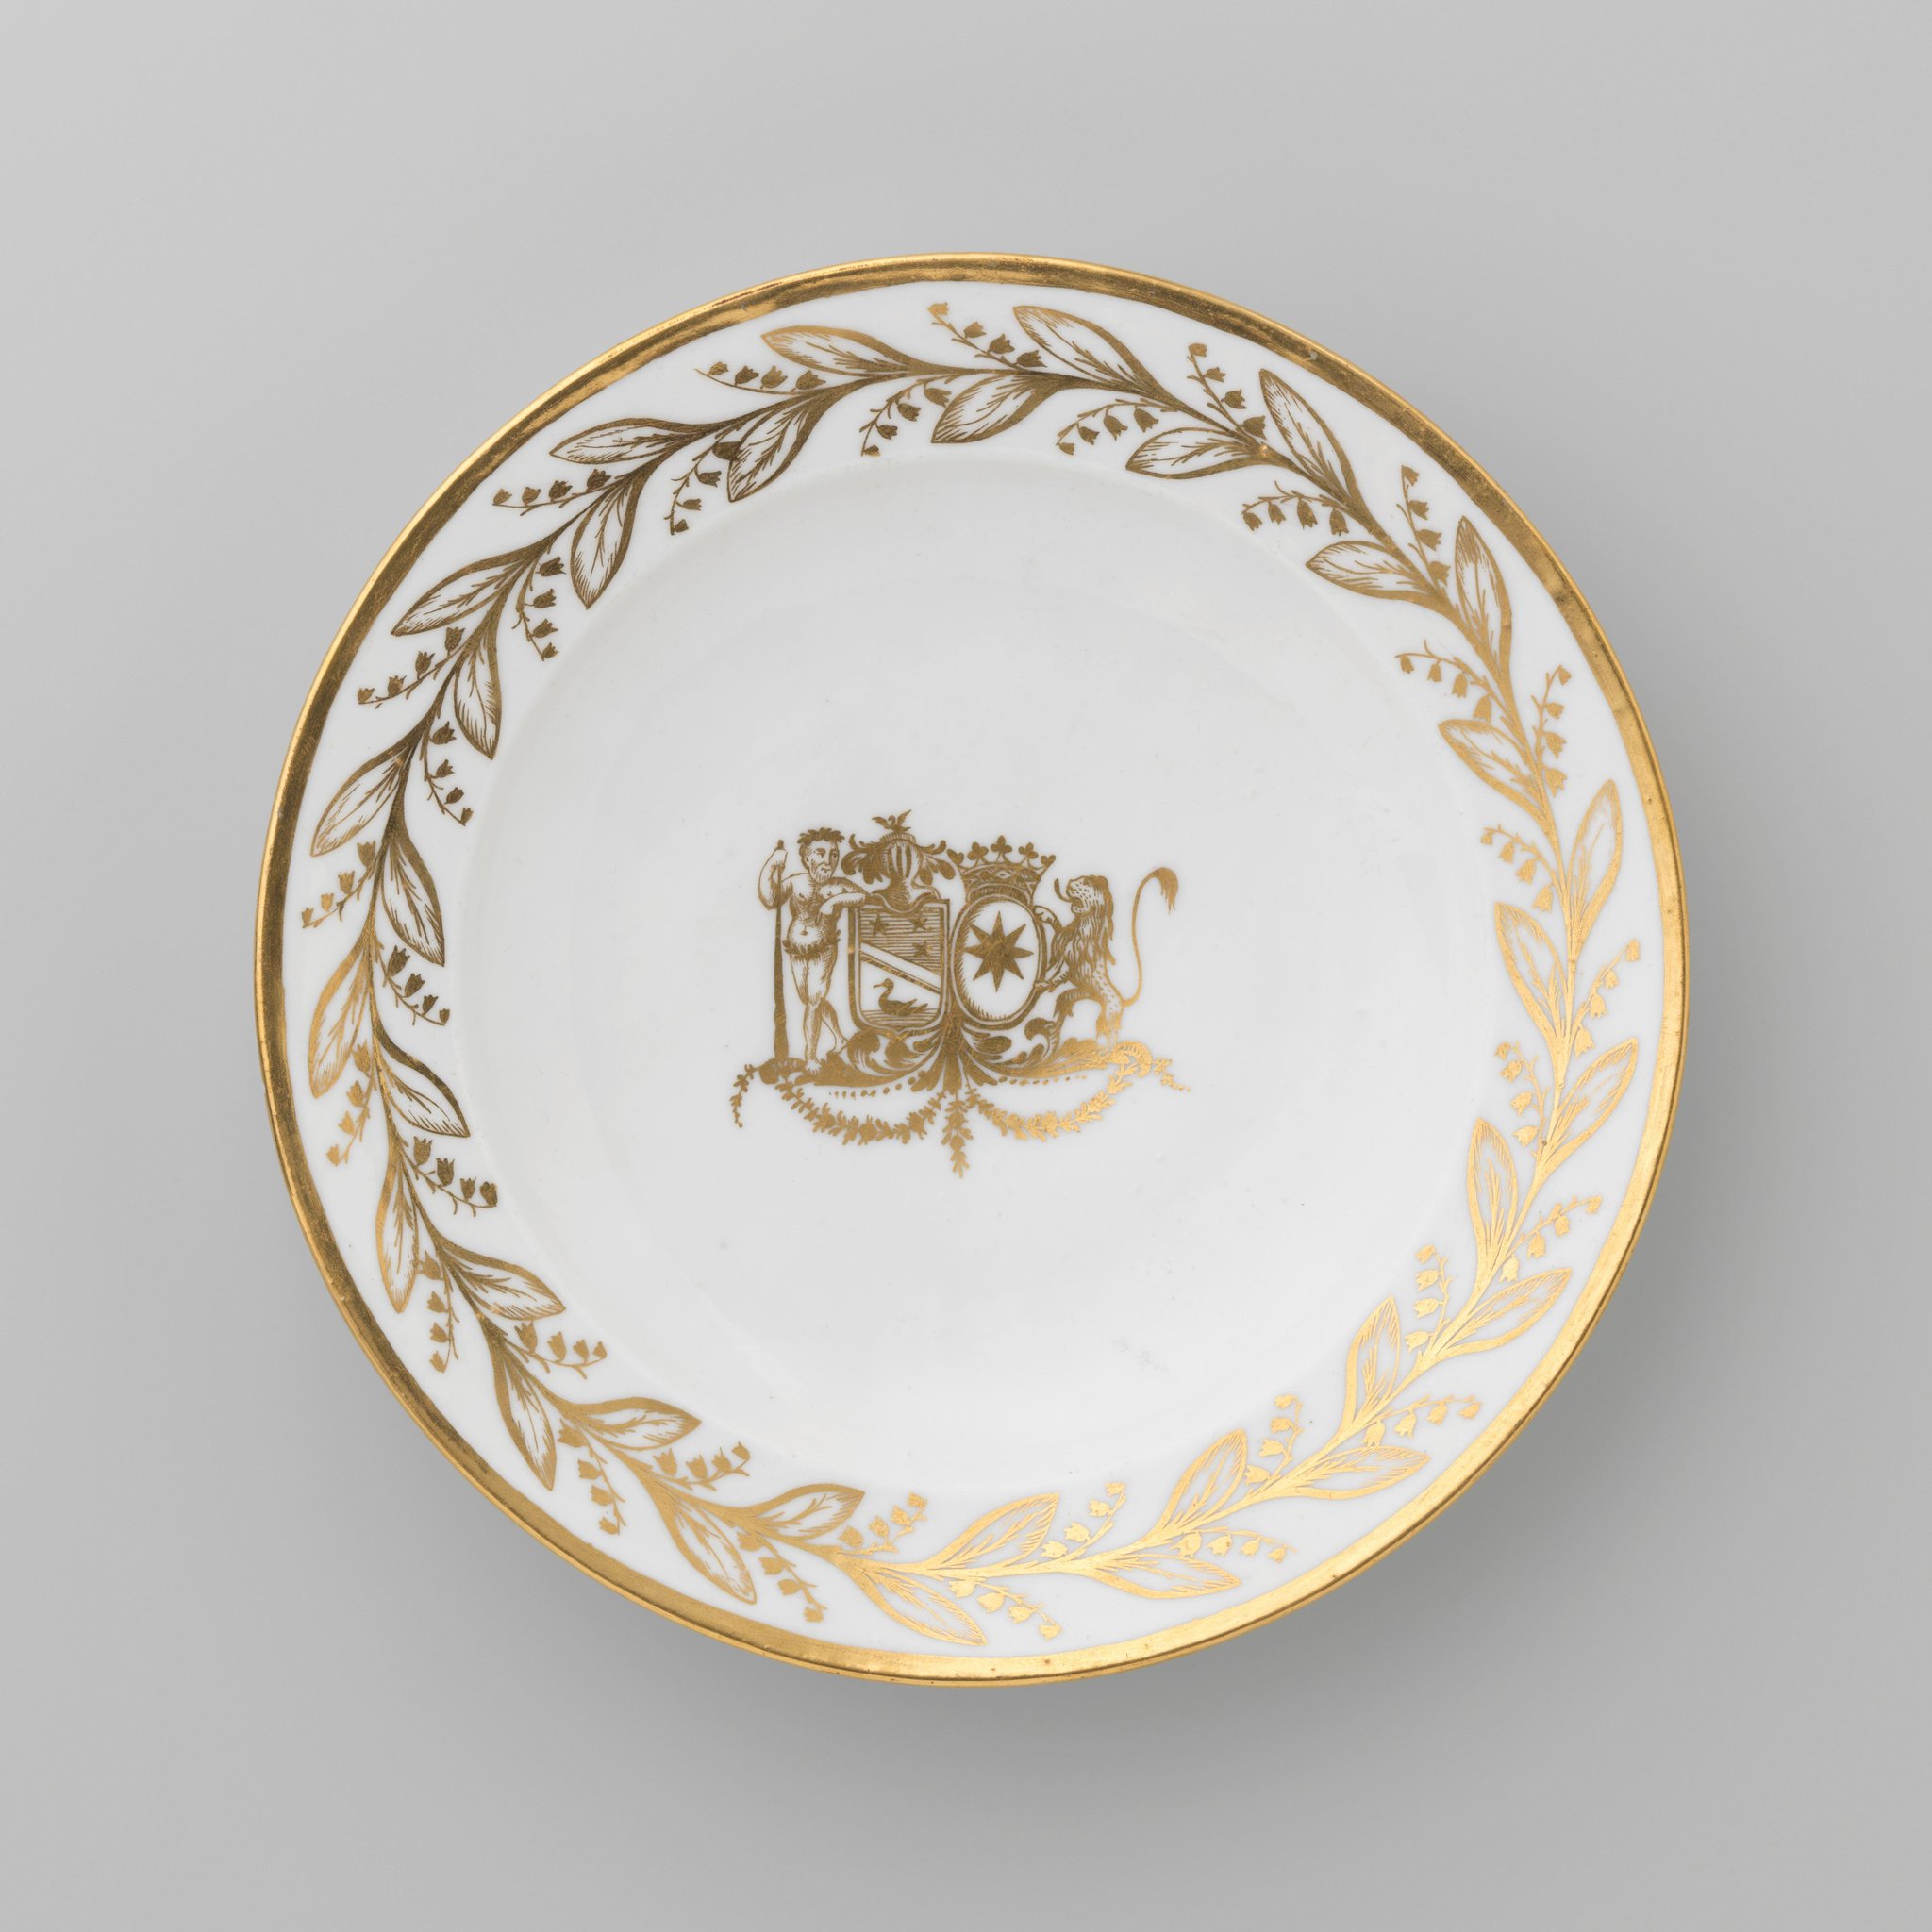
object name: service set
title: Plate with the coat of arms of Hendrik Peter Godfried Quack and Isabella Gertraud von Carnap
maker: Anonymous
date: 1790-1800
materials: glaze, gold, paint, porcelain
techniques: firing, forming, gilding, turning, vitrification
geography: paris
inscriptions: mark: ‘L’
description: Diep bord van porselein, beschilderd op het glazuur met goud. Op het plat het alliantiewapen van Hendrik Peter Godfried Quack en Isabella Gertraud von Carnap. De rand met een bloemrank en een gouden band. Een proen op de onderzijde. Gemerkt op de onderzijde met L.